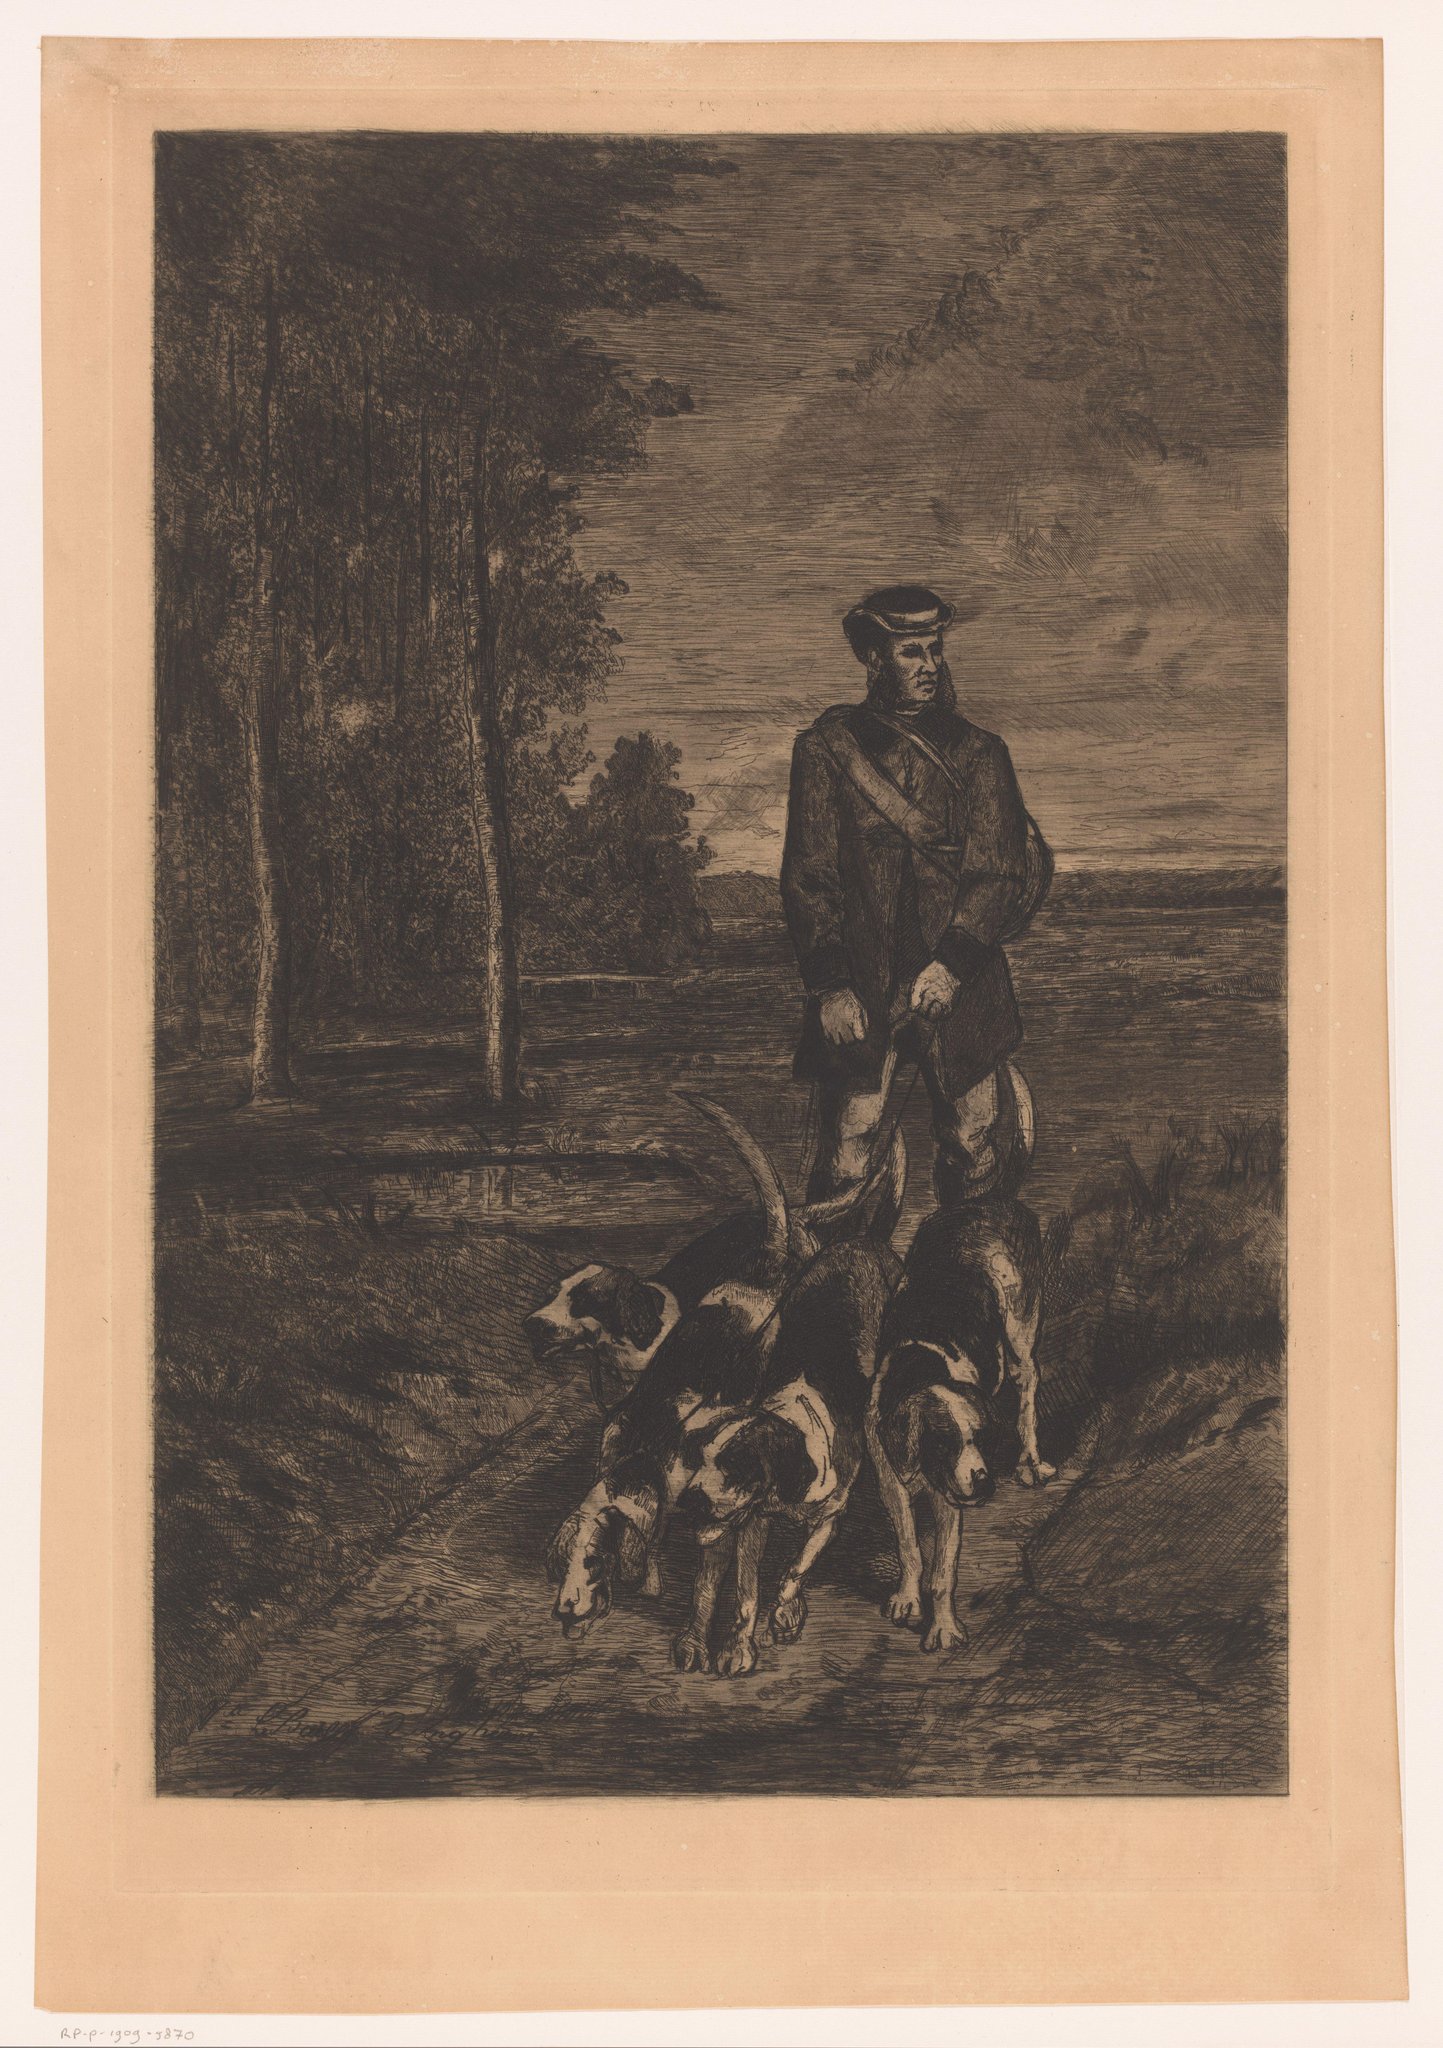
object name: print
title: Jagersknecht met vier honden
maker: vicomte arthur-jean le bailly dinghuem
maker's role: print maker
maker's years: 1839-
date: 1850-1899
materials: paper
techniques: etching, intaglio, roulette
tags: landscapes, hunting dogs, adult man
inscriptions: collector's mark: Lugt 2228